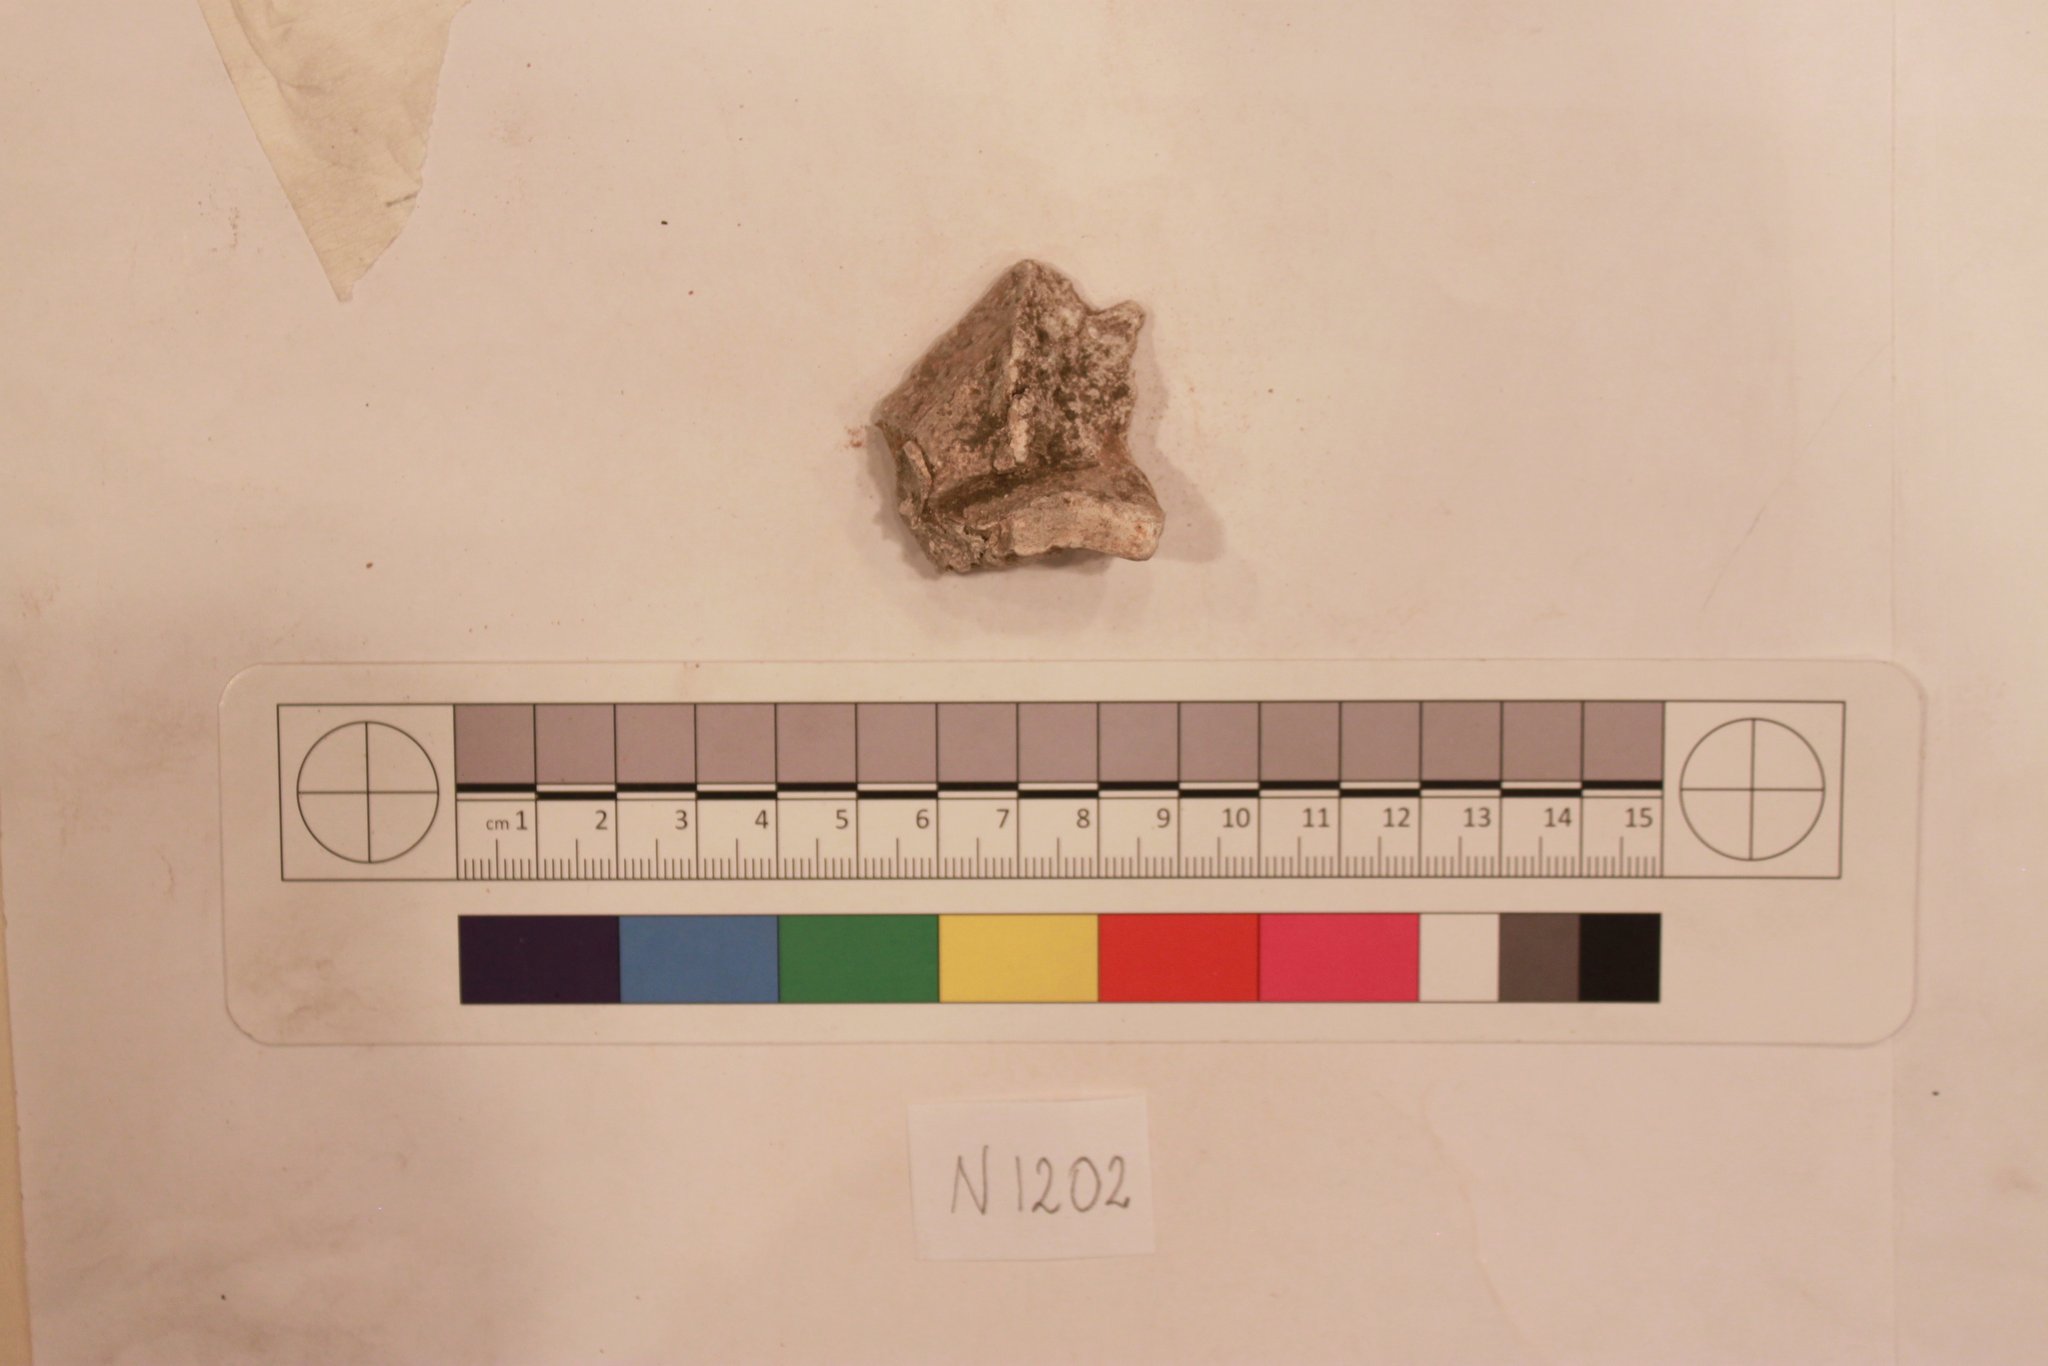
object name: fragment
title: Stucco Fragment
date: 701-1200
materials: plaster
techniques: carving, painting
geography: iran